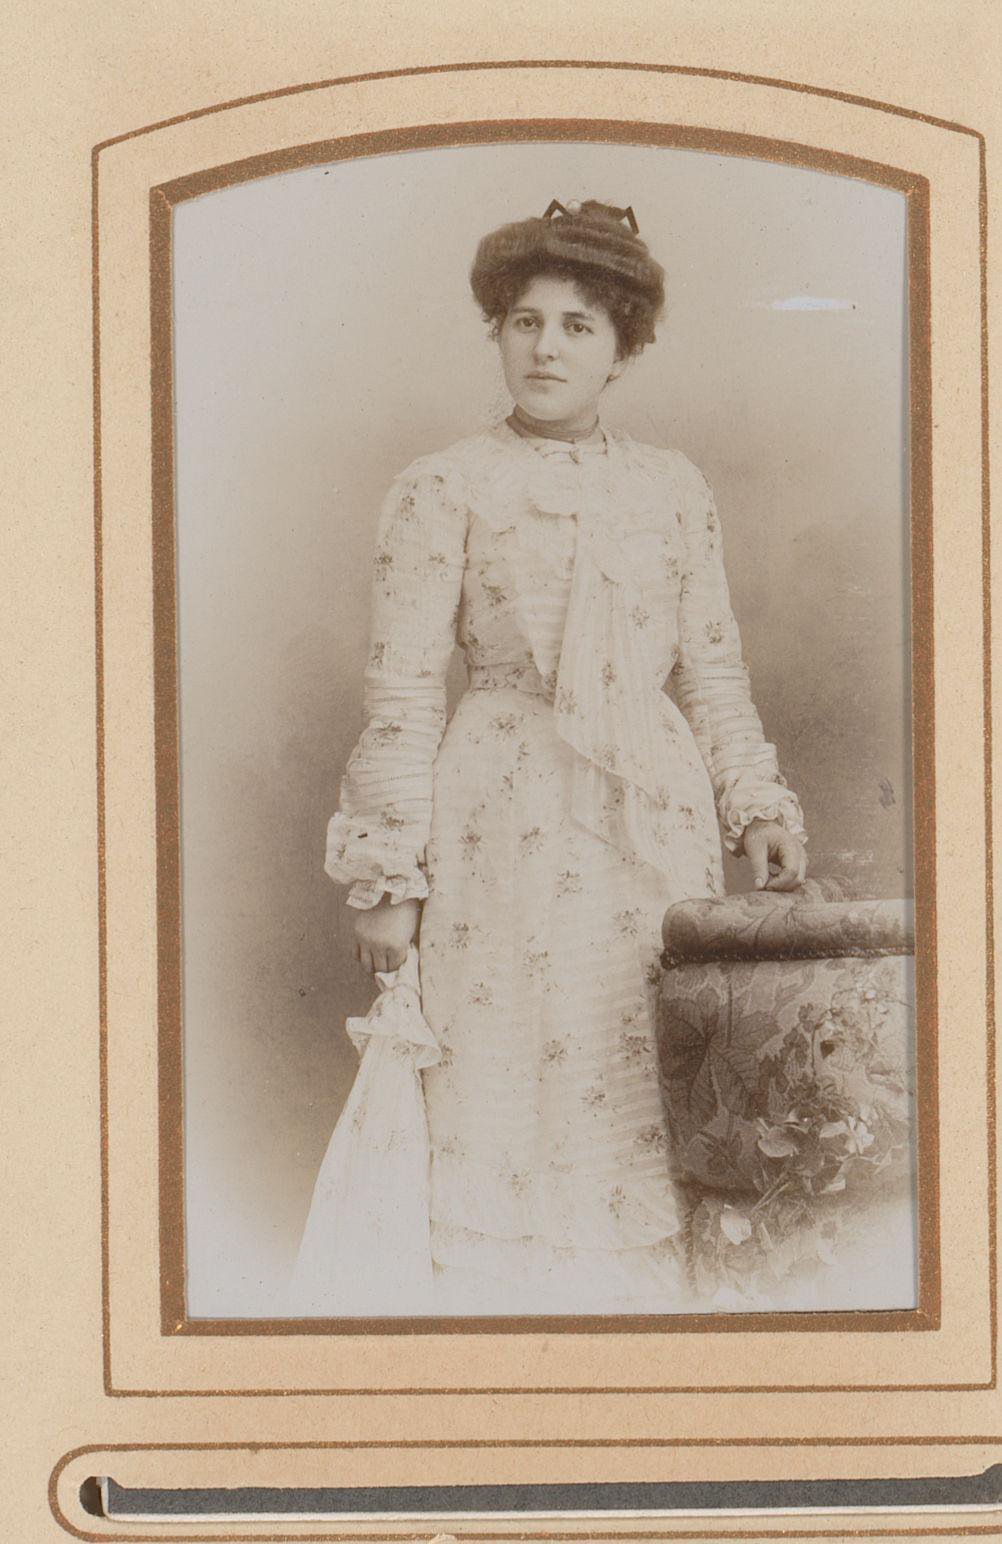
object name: carte de visite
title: Portret van een vrouw staand bij een stoel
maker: wilhelm kersten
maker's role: fotograaf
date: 1880-1911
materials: cardboard, photographic support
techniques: collodion silver print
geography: berlin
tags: historical persons - bb - woman, standing figure - aa - female human figure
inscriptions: inscription: ‘W. Kersten/ Berlin W/ Krausenstr. 35’, inscription: ‘Globus Atelier/ Berlin W/ Leipziger-str 132/ 137’